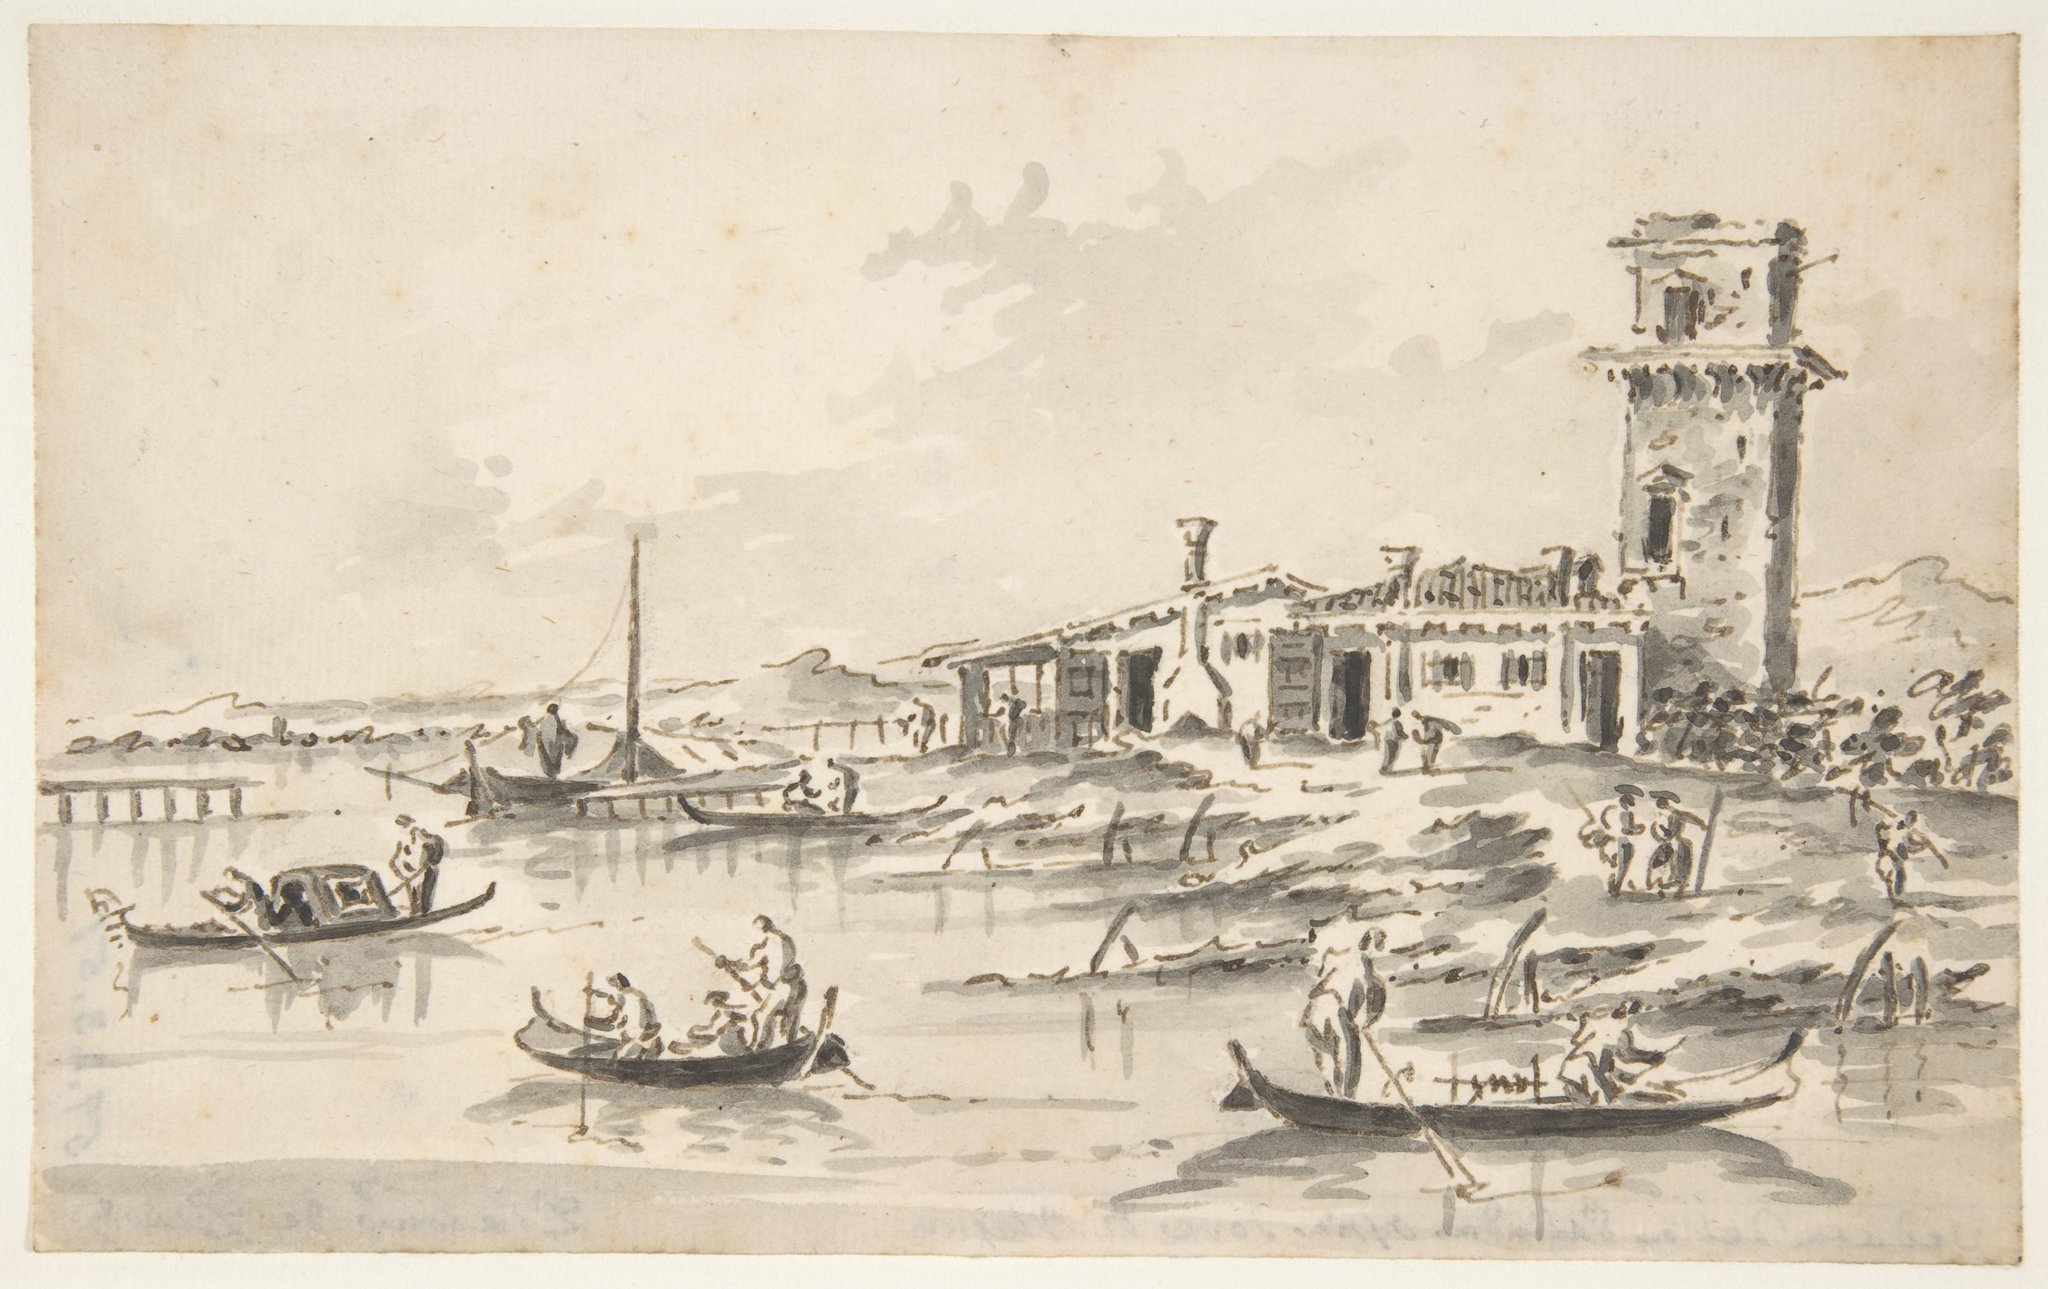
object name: drawing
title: The Tower at Marghera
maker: giacomo guardi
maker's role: artist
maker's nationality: italian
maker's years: 1764-1835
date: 1764-1835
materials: chalk, graphite, ink, lead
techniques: brush, pen, wash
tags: buildings,men,sailing,boats